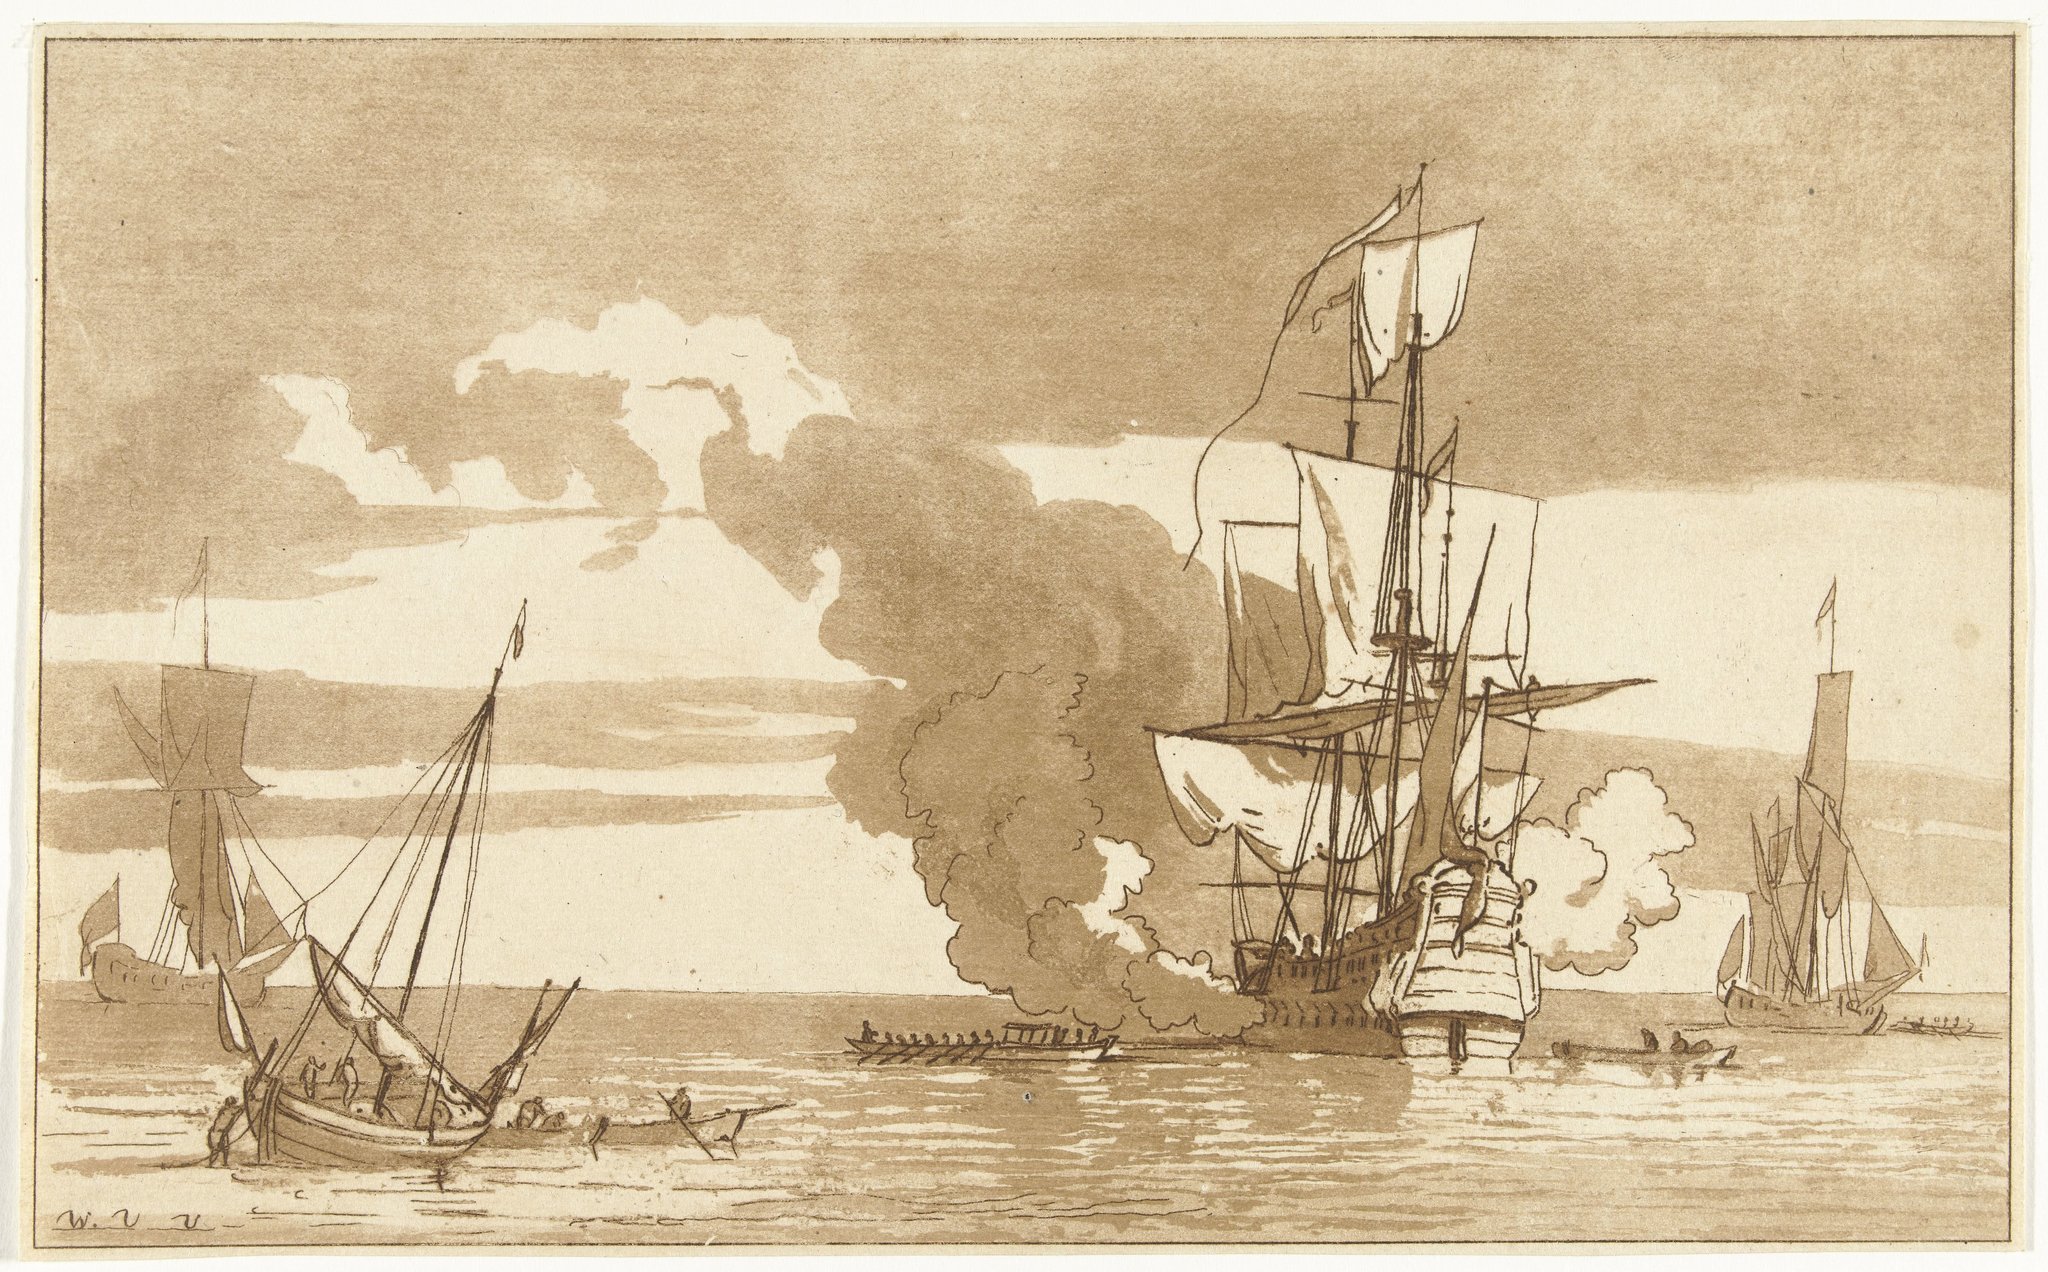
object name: print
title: Zeeslag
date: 1778-1832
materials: paper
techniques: aquatint, etching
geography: netherlands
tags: battle (+ sailing-ships)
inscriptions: collector's mark: Lugt 2228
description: Een oorlogsschip bij windstilte met slappe zeilen lost een kanonschot. Aan weerszijden twee sloepen, in de verte twee kleinere schepen. Een ander schip wordt door de bemanning aan het strand getrokken.